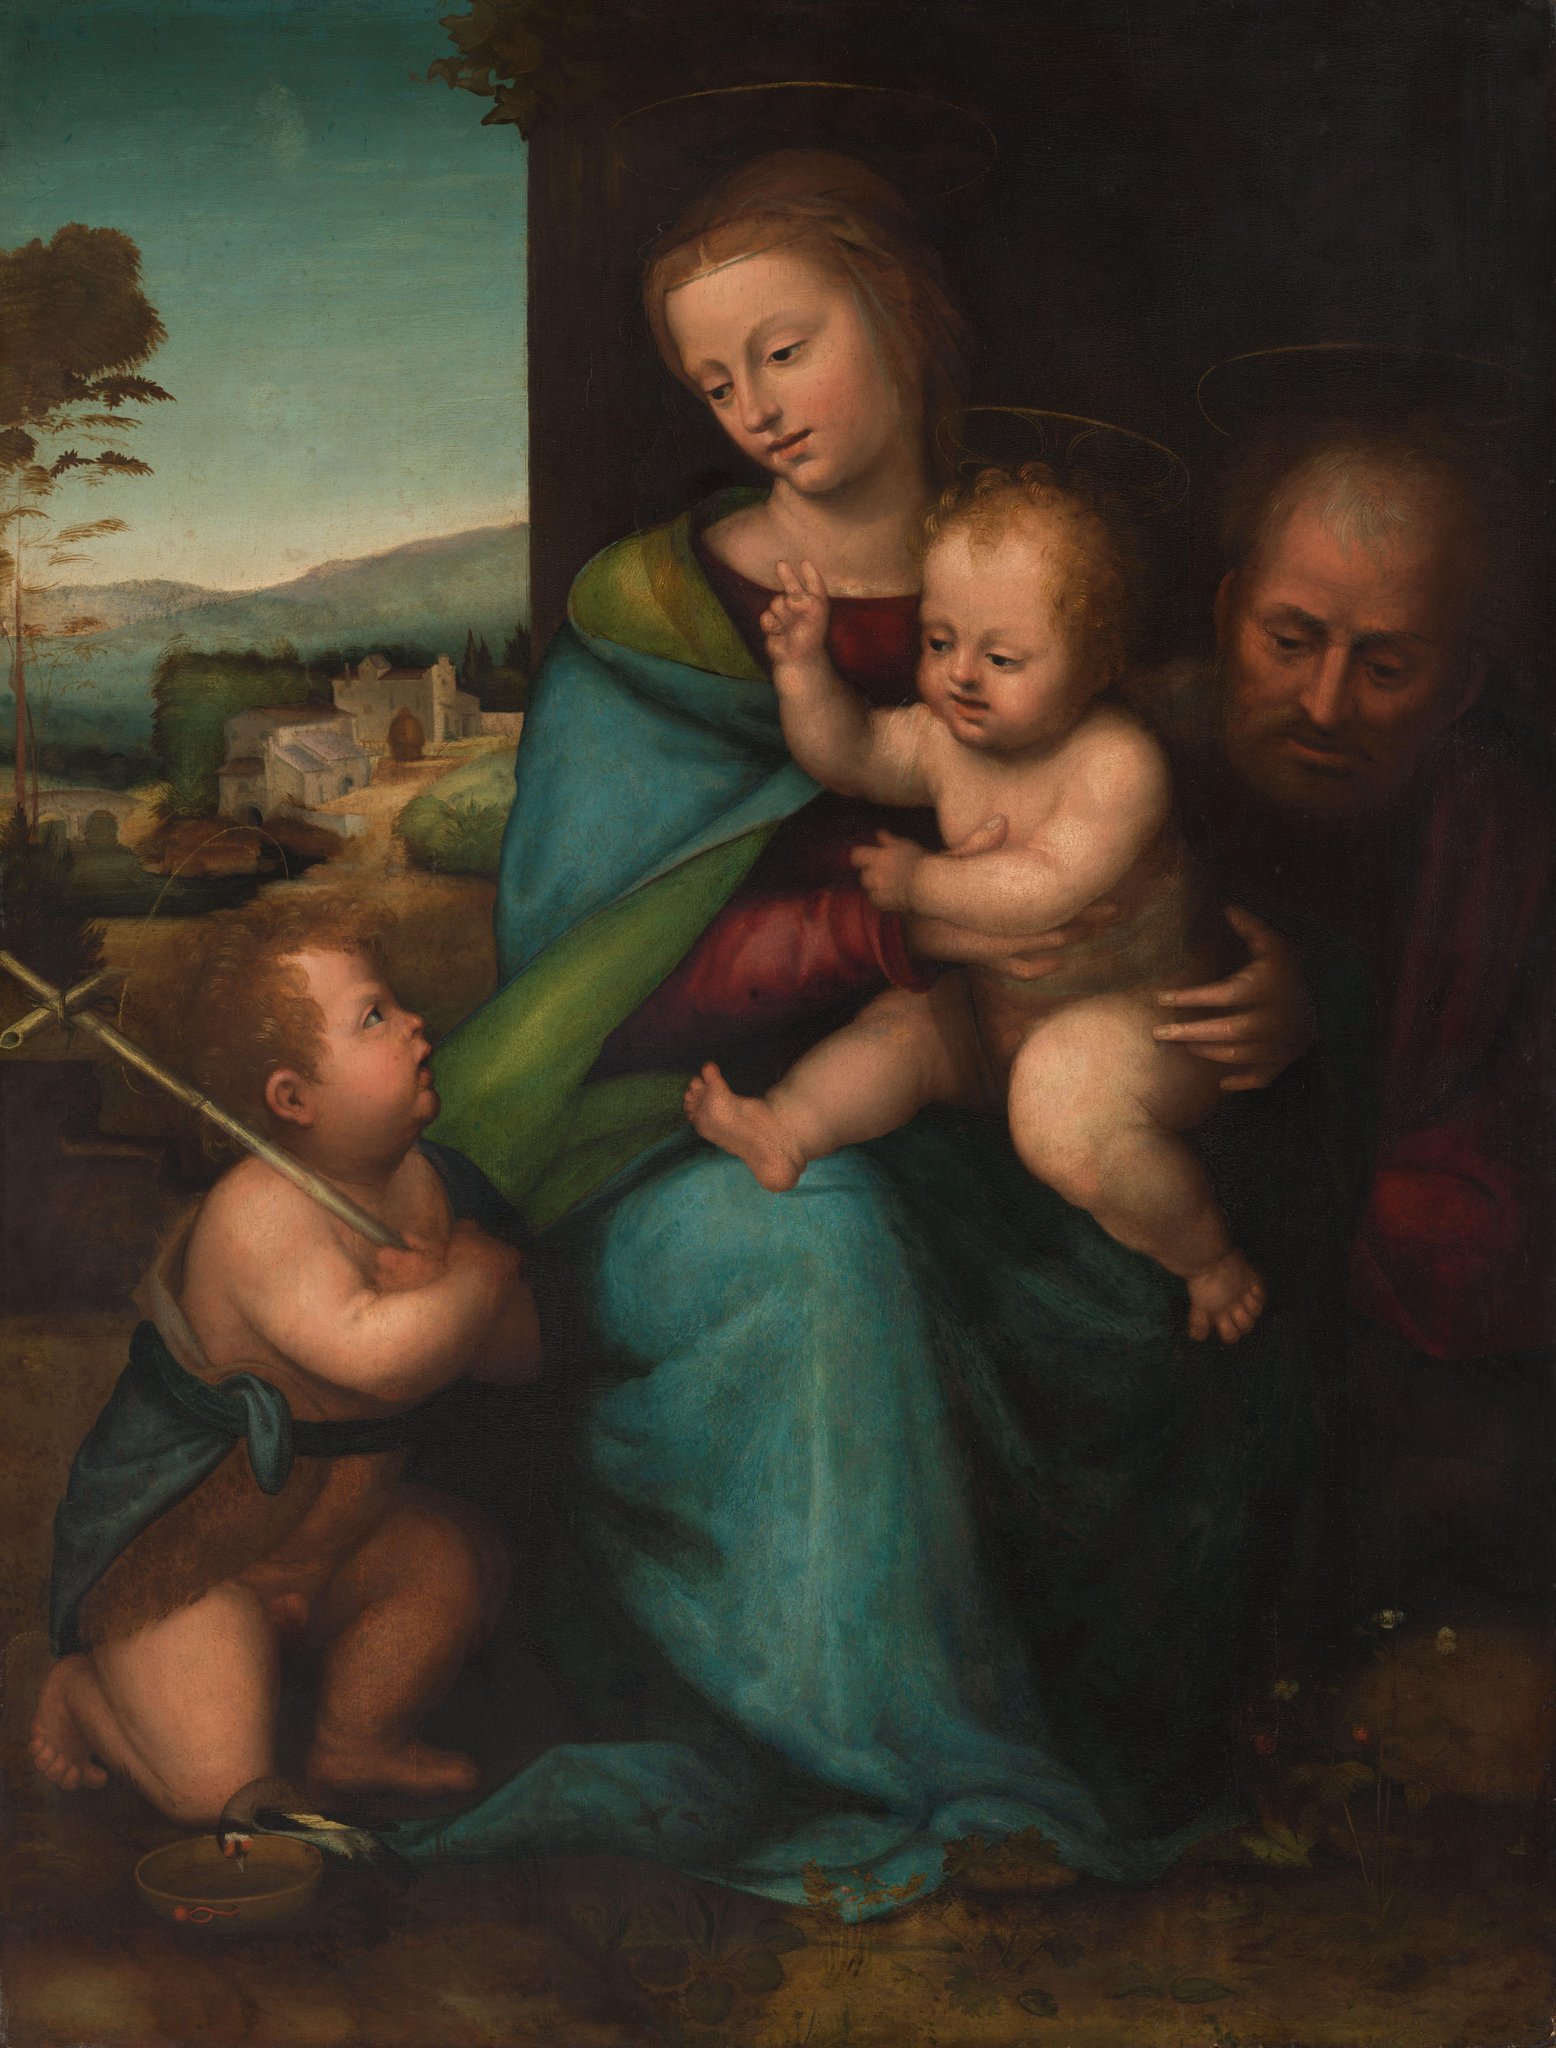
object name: painting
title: The Holy Family with the Infant John the Baptist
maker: bartolommeo (fra)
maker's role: draughtsman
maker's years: 1472-1517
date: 1505-1515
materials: oil, panel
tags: holy family with john the baptist (as child)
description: De Heilige Familie met Johannes de Doper als kind. Links drinkt een vink uit een bakje met water.